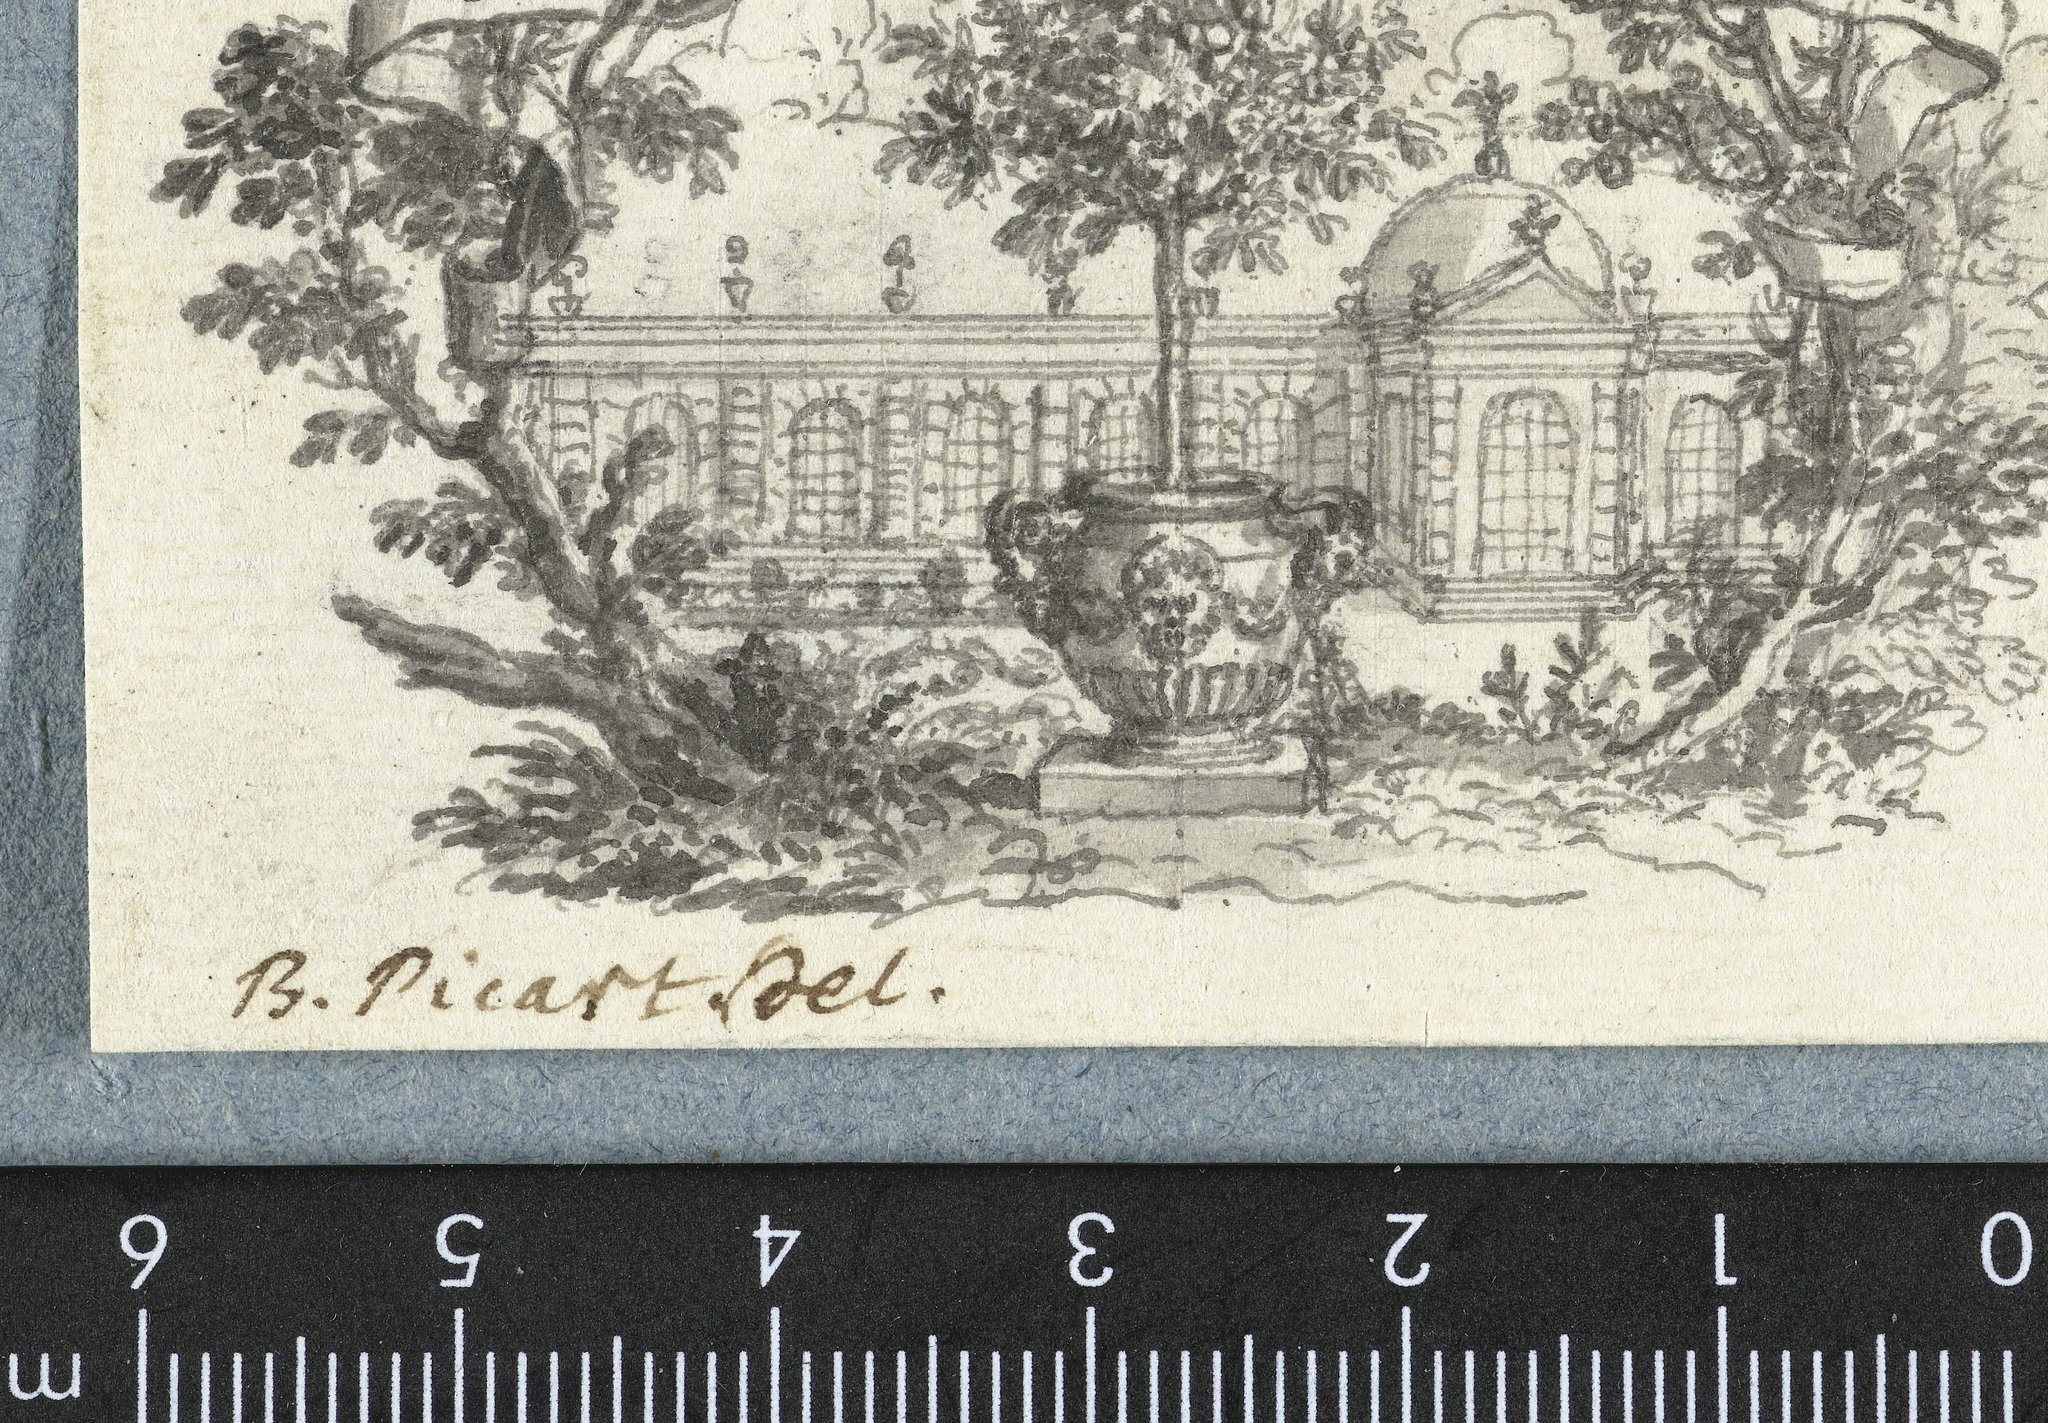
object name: design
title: Vignet met boom in pot voor gebouw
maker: bernard picart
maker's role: draughtsman, print maker, publisher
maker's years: 1673-1733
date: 1683-1733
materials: ink, paper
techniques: brush, pen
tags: trees (+ plants used symbolically)